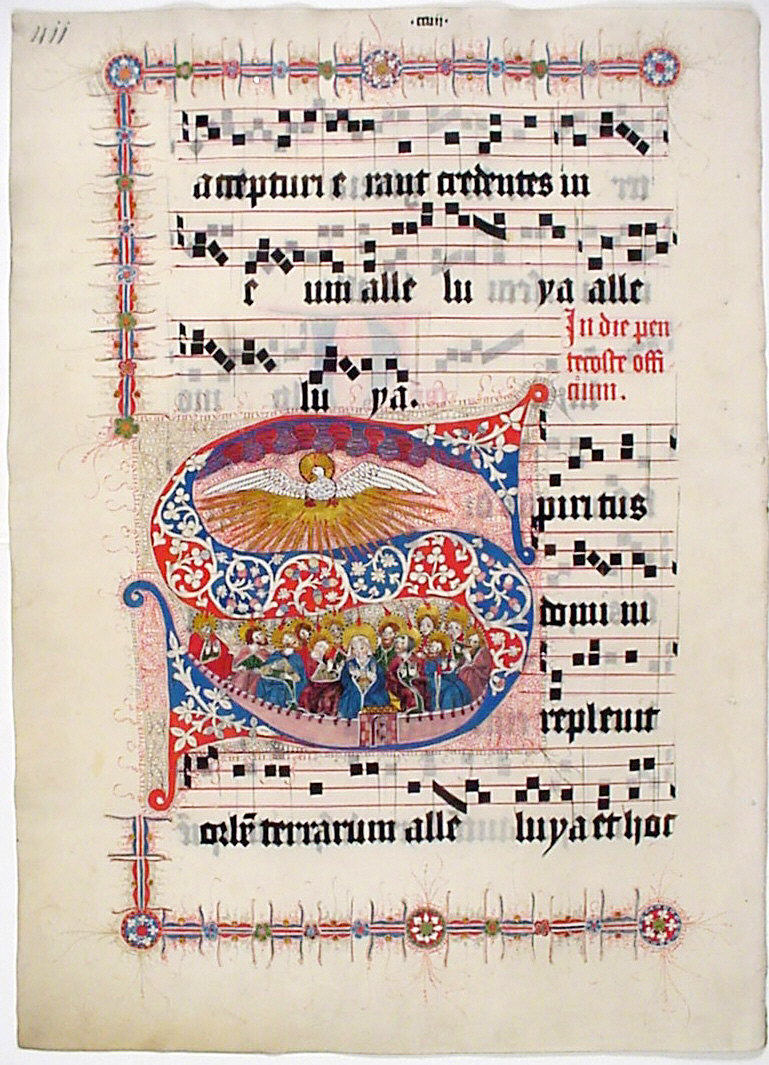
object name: gradual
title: Manuscript Leaf with Initial S, from a Gradual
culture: german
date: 1426-1450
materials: ink, metal leaf, parchment, paint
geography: germany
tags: birds,women,music